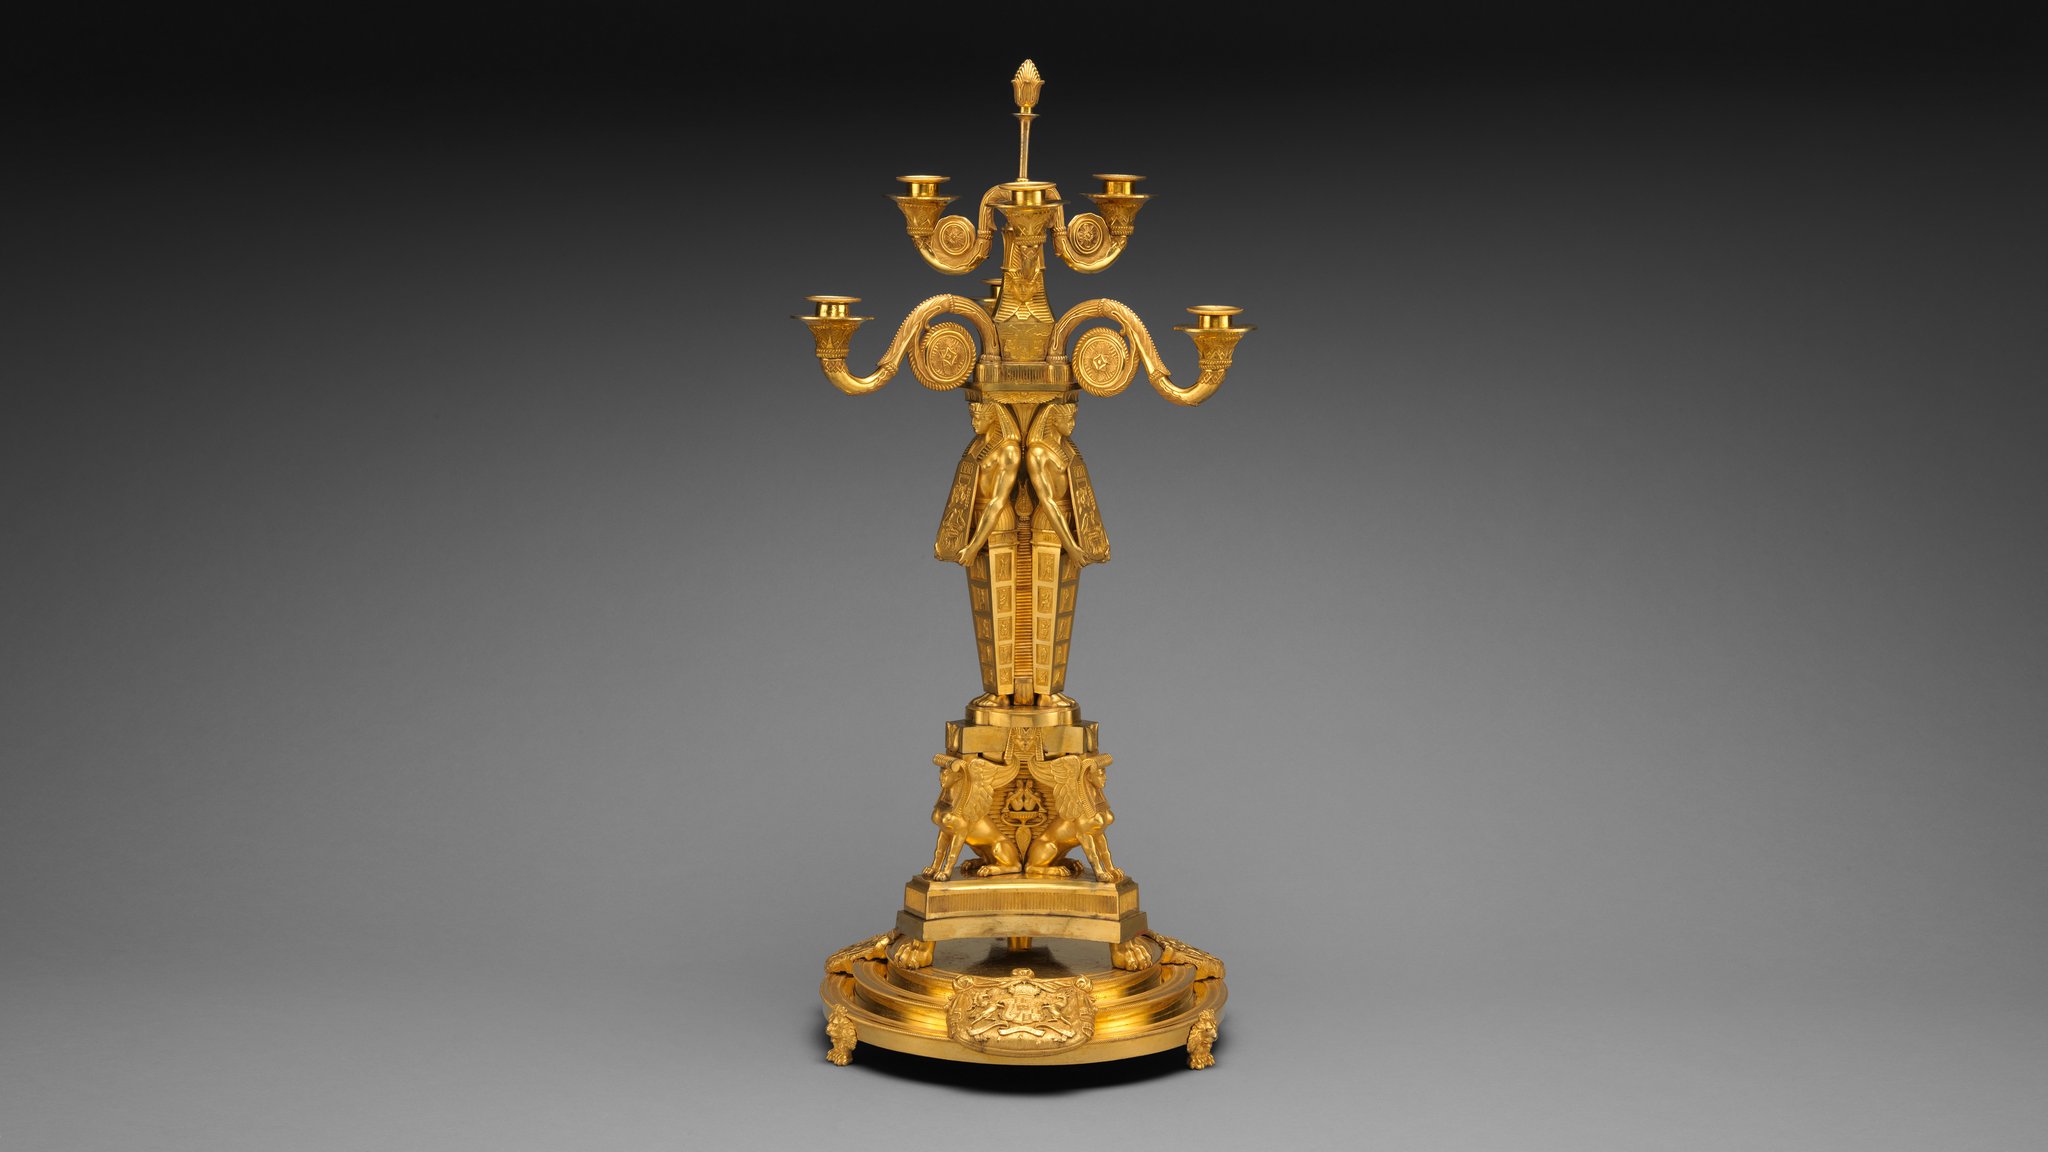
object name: candelabrum and stand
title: Egyptomania candelabrum (one of a pair)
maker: alexis decaix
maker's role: maker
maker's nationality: british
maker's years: 1778-1811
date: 1802-1806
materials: bronze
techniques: gilding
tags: sphinx